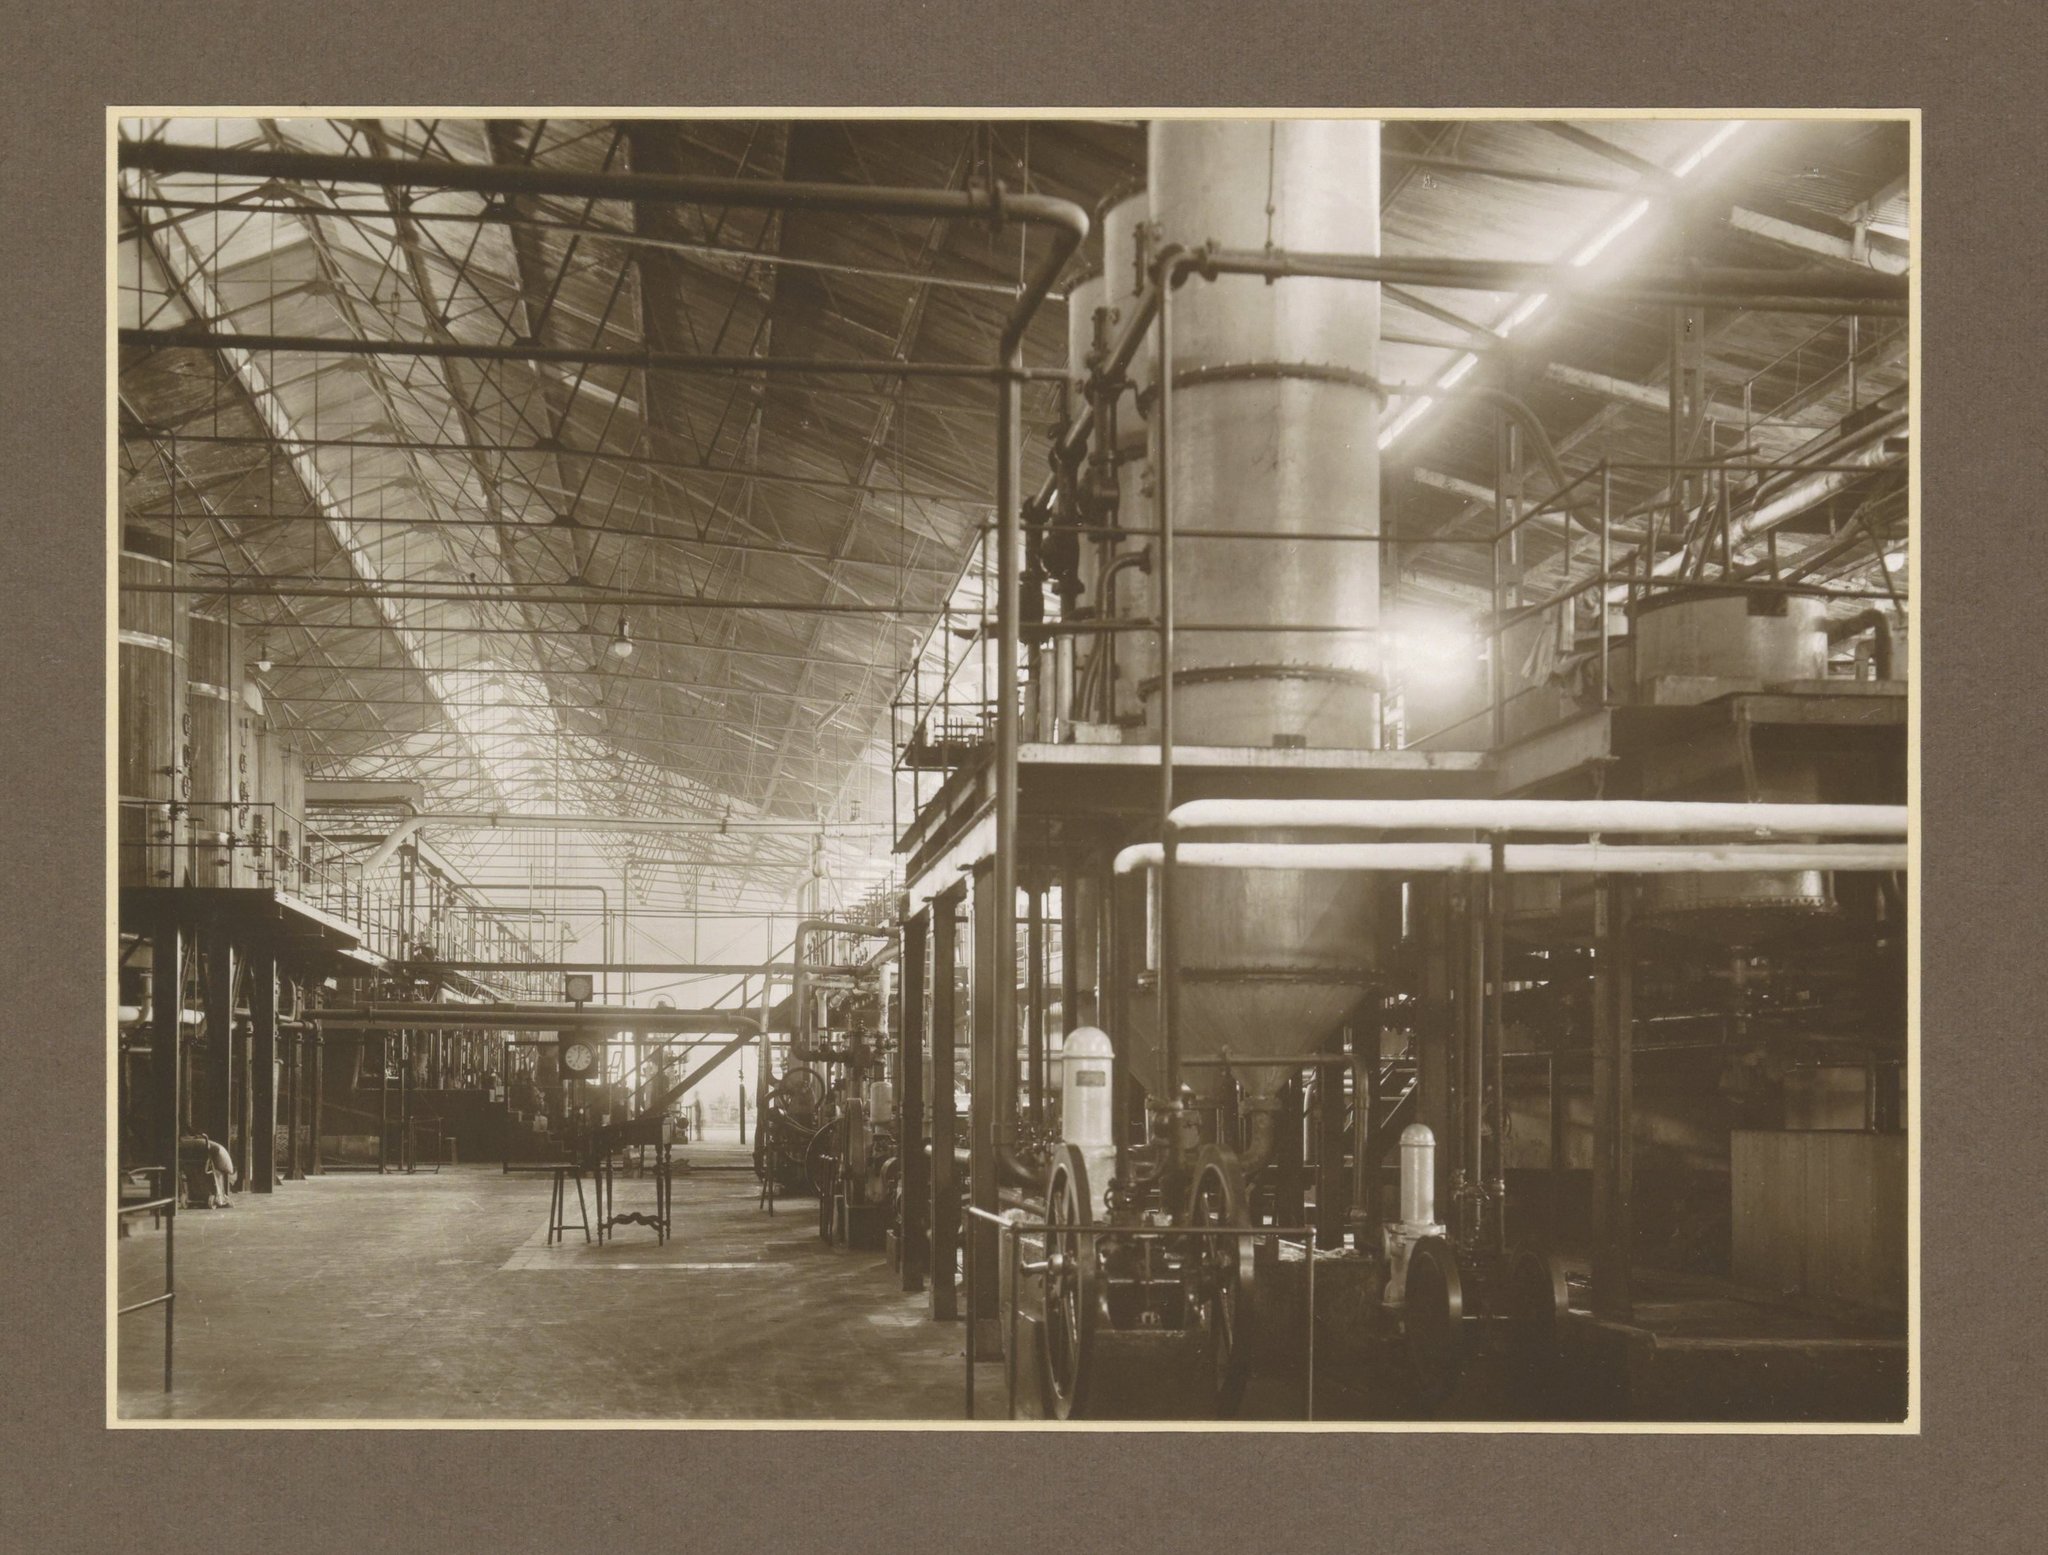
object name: photograph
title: Sf. Goedo Middenfabriek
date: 1925-1930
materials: cardboard, paper, photographic support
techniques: gelatin silver print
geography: jombang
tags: plantation, factory-interior, machine shop, plants and herbs: sugarcane, sugar, dutch east indies, the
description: Onderdeel van Fotoalbum met opnames van vier suikerfabrieken op Java.